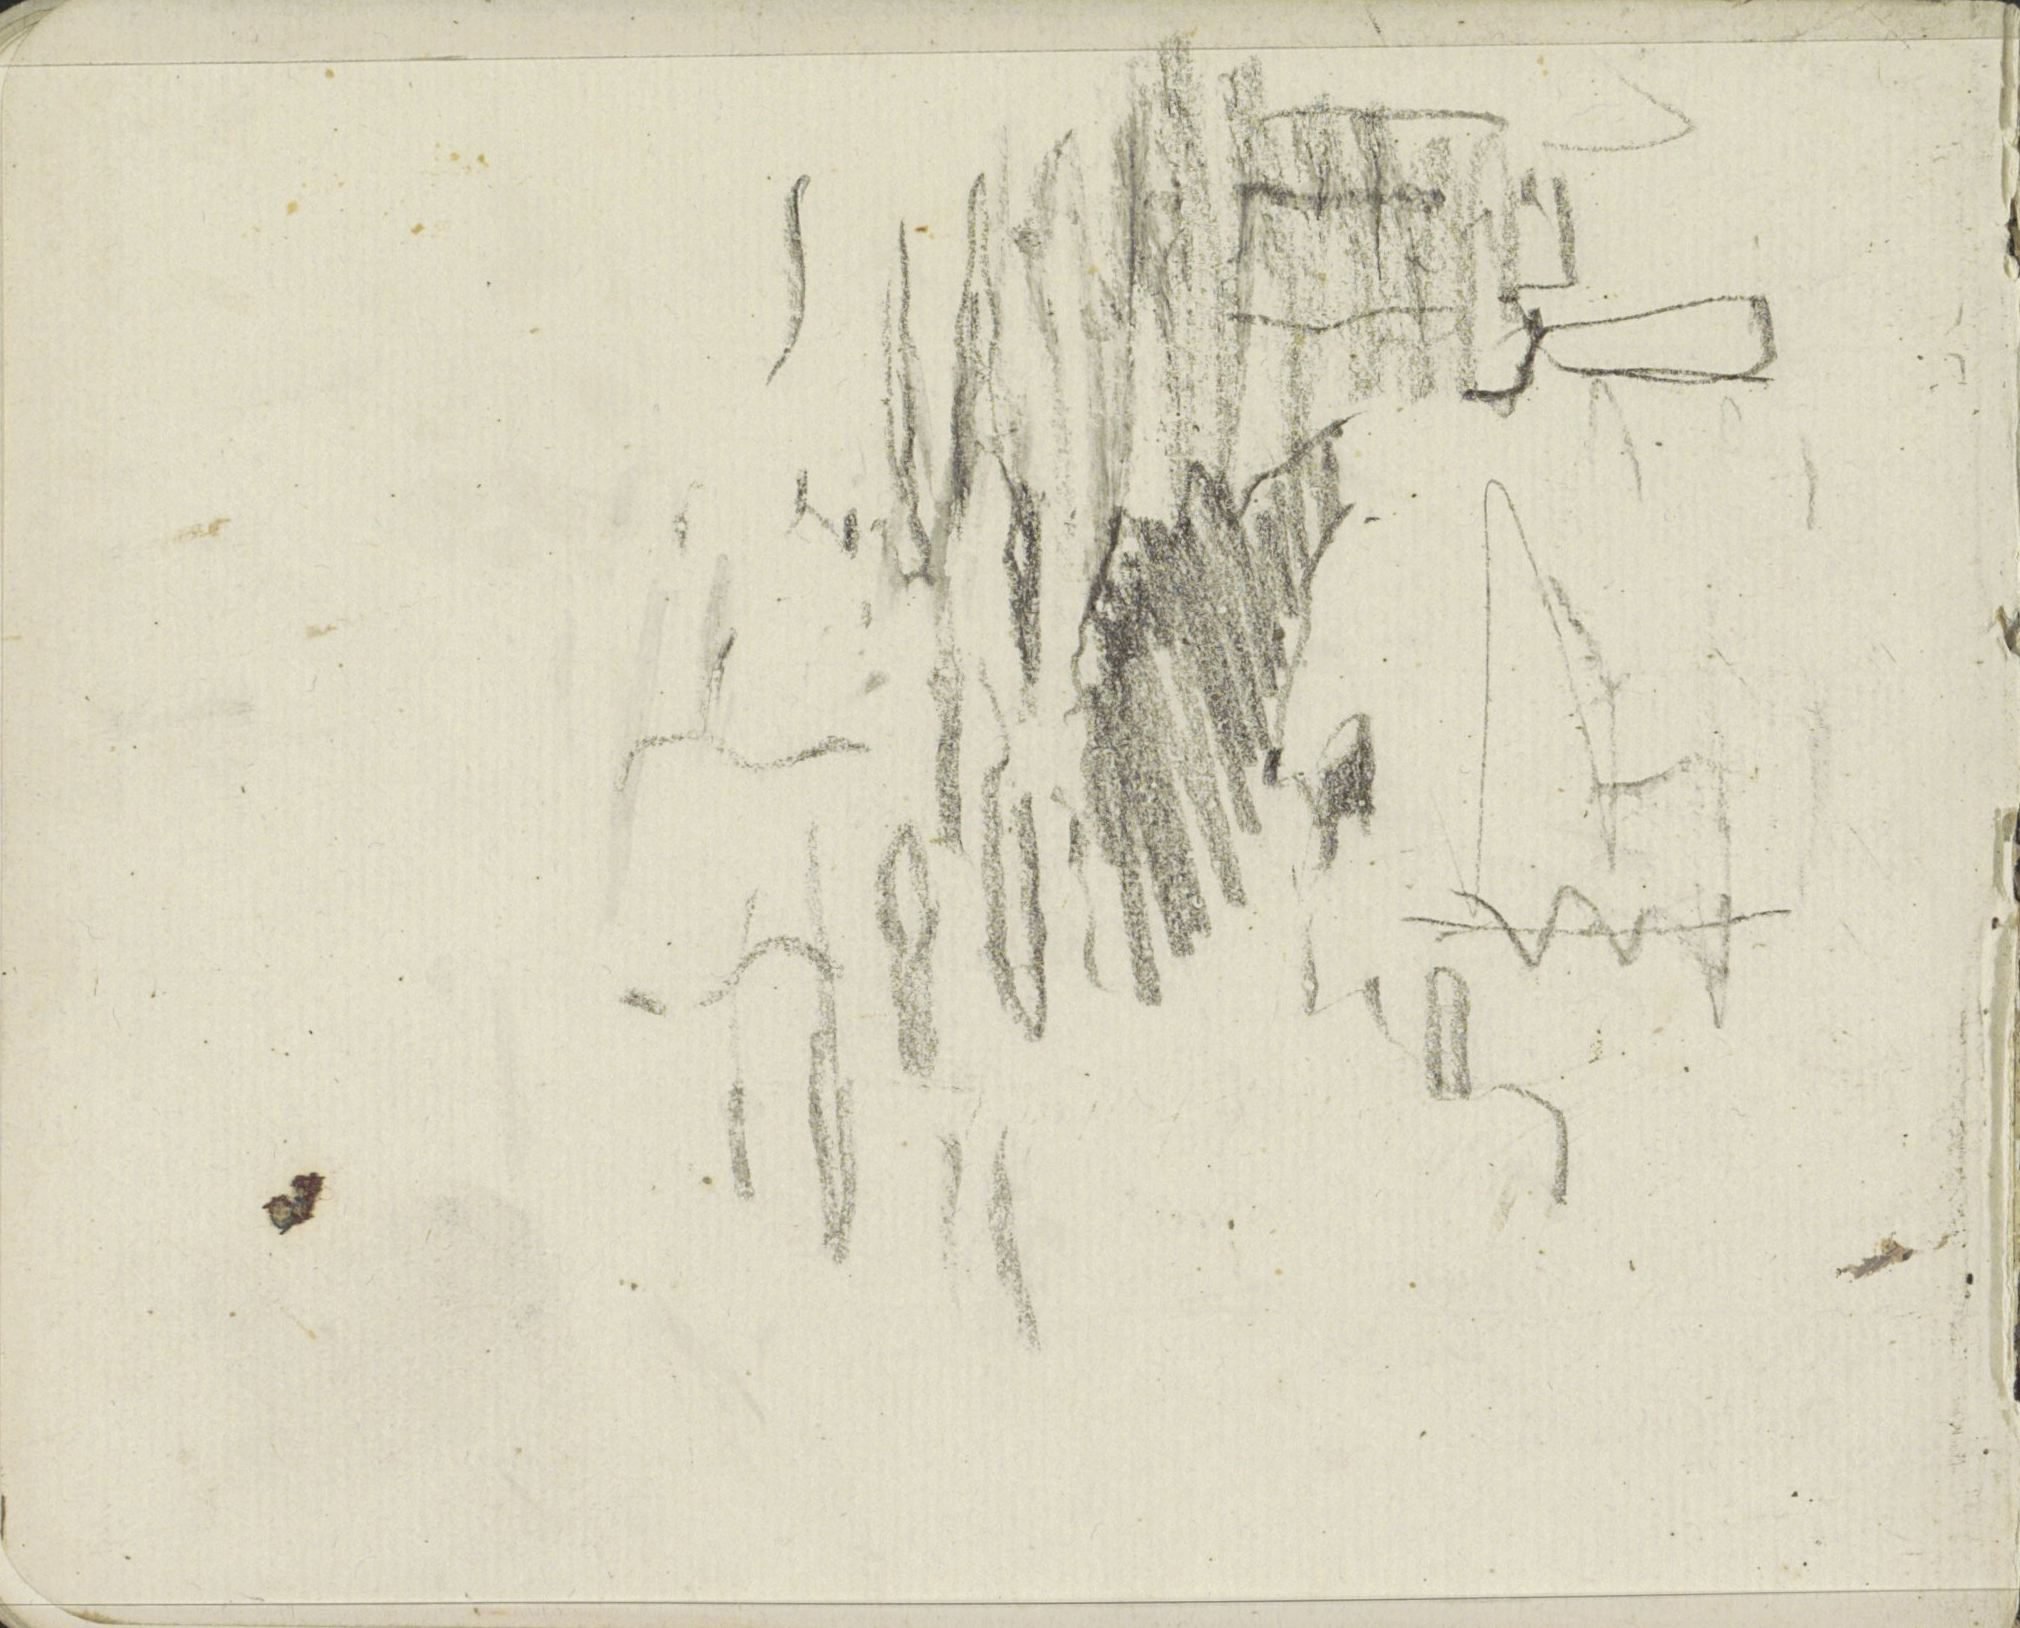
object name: sketchbook leaf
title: Landschap, mogelijk met water en bebouwing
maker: willem witsen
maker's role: draughtsman, painter, print maker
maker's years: 1860-1923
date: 1915-1921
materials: chalk, paper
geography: amsterdam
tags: landscapes with waters, waterscapes, seascapes (in the temperate zone), architecture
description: Blad 16 verso uit een schetsboek met 23 bladen.